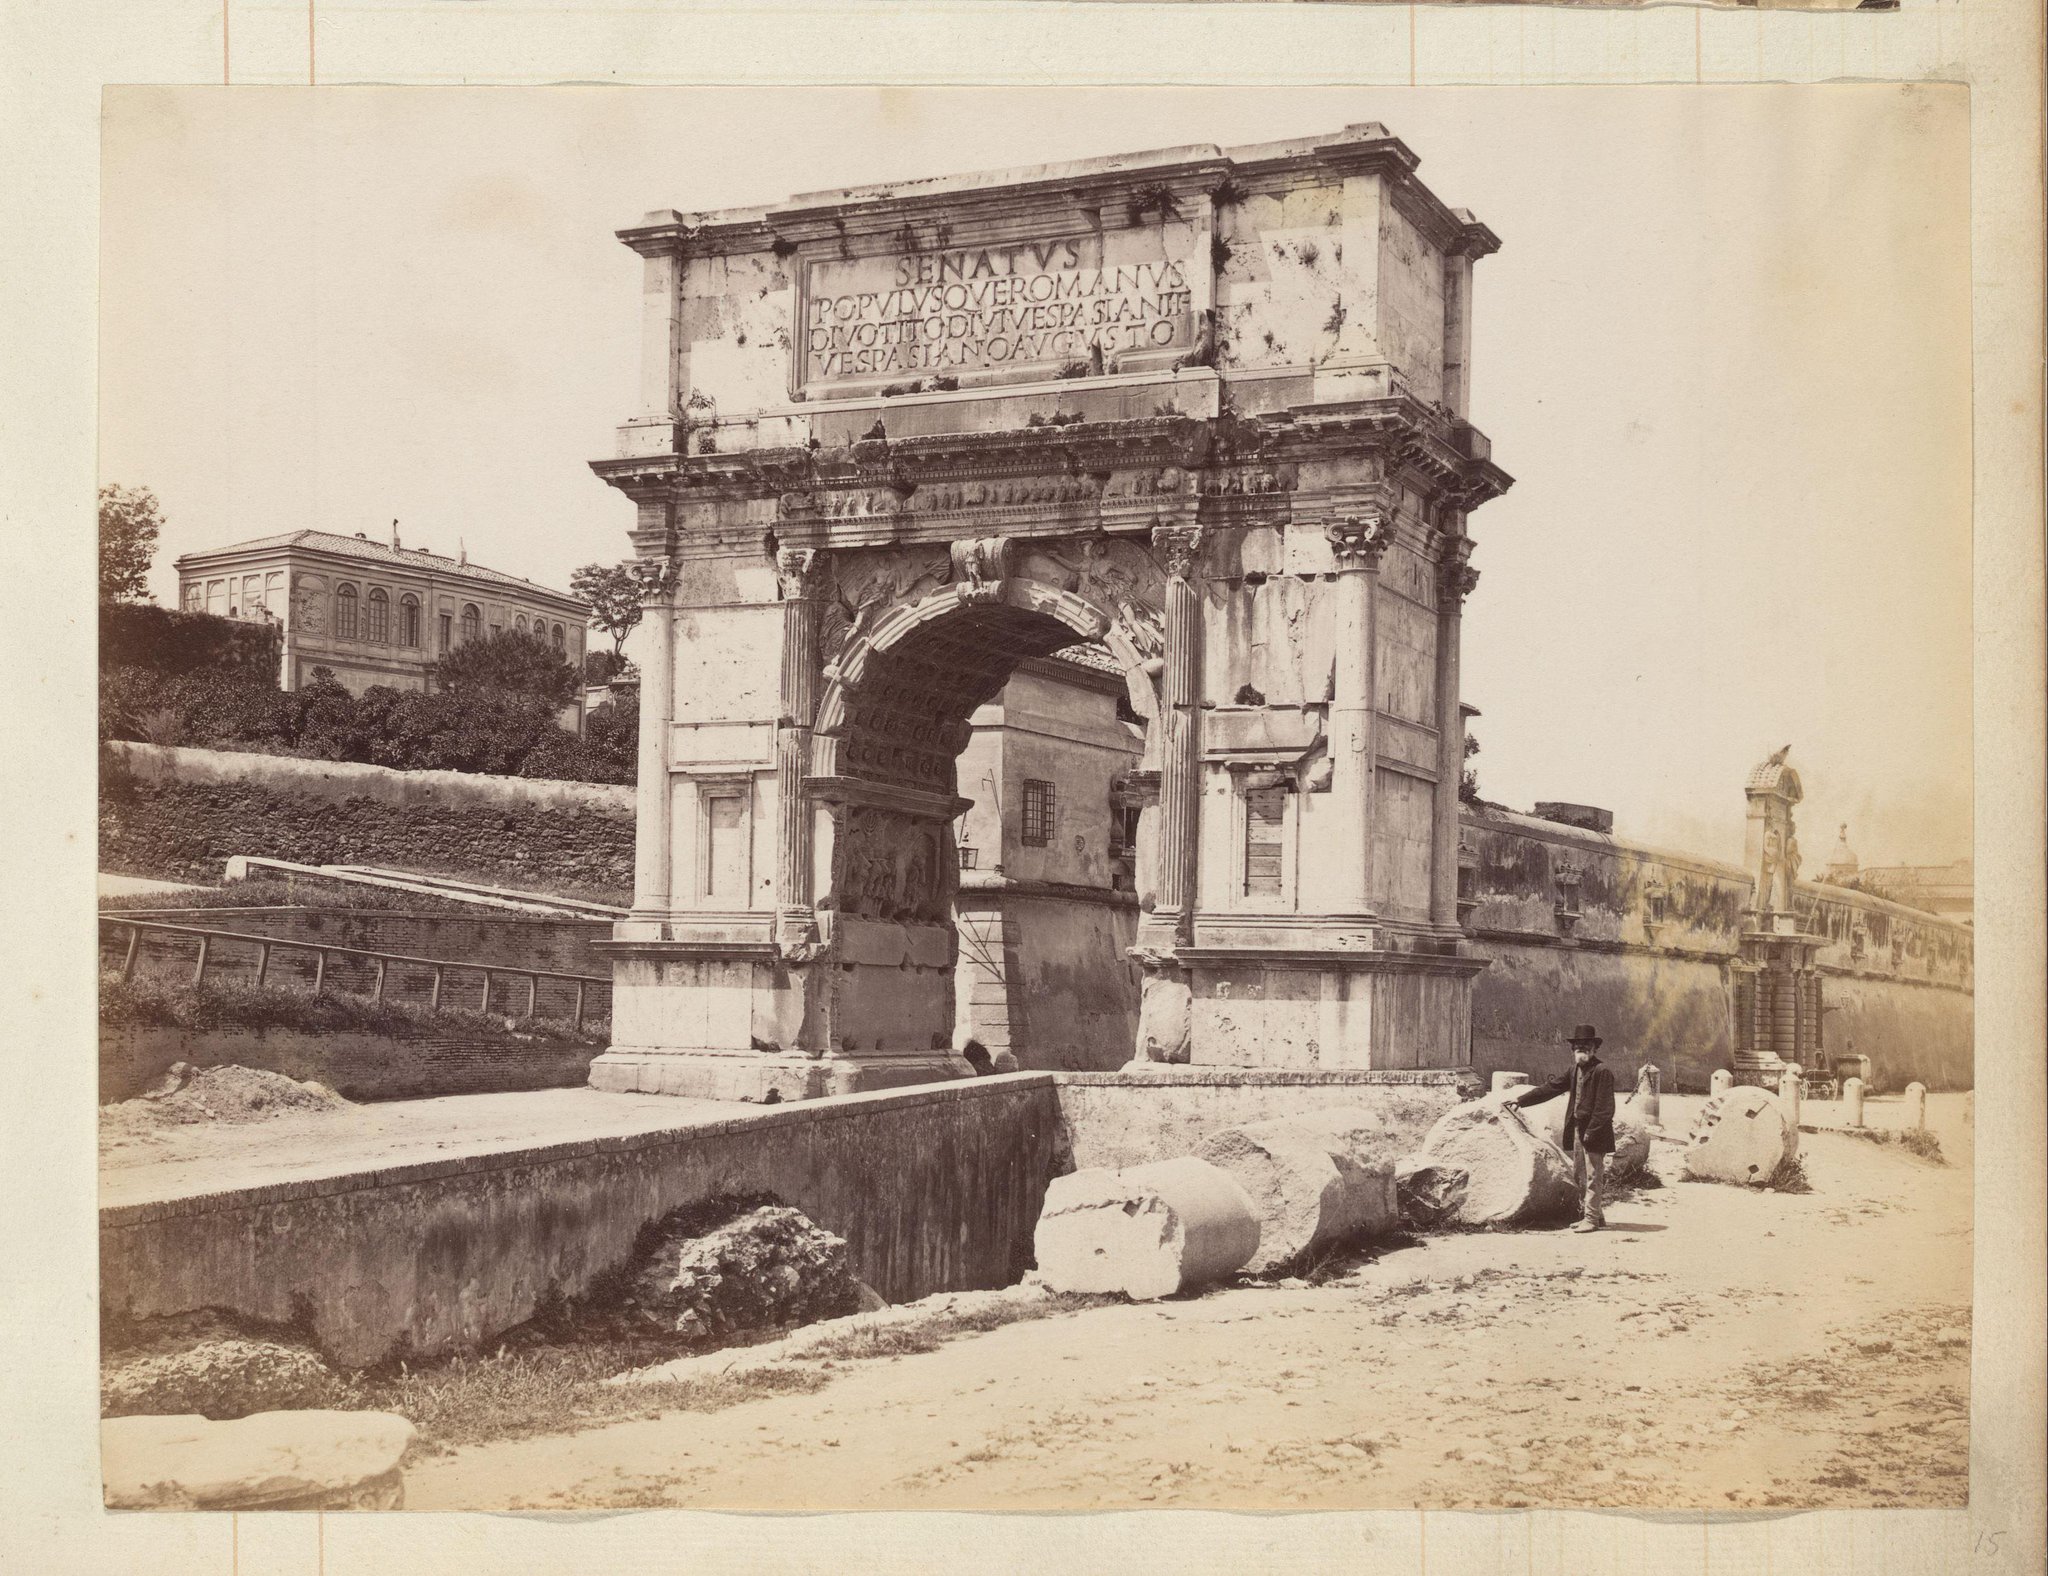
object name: photograph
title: Man poserend bij de Titusboog op het Forum Romanum te Rome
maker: Anonymous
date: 1880-1900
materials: paper, photographic support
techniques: albumen print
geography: rome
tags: triumphal arch, rome